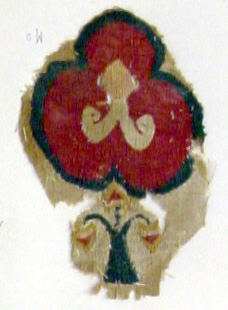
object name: textile fragment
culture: coptic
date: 401-500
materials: linen, wool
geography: egypt